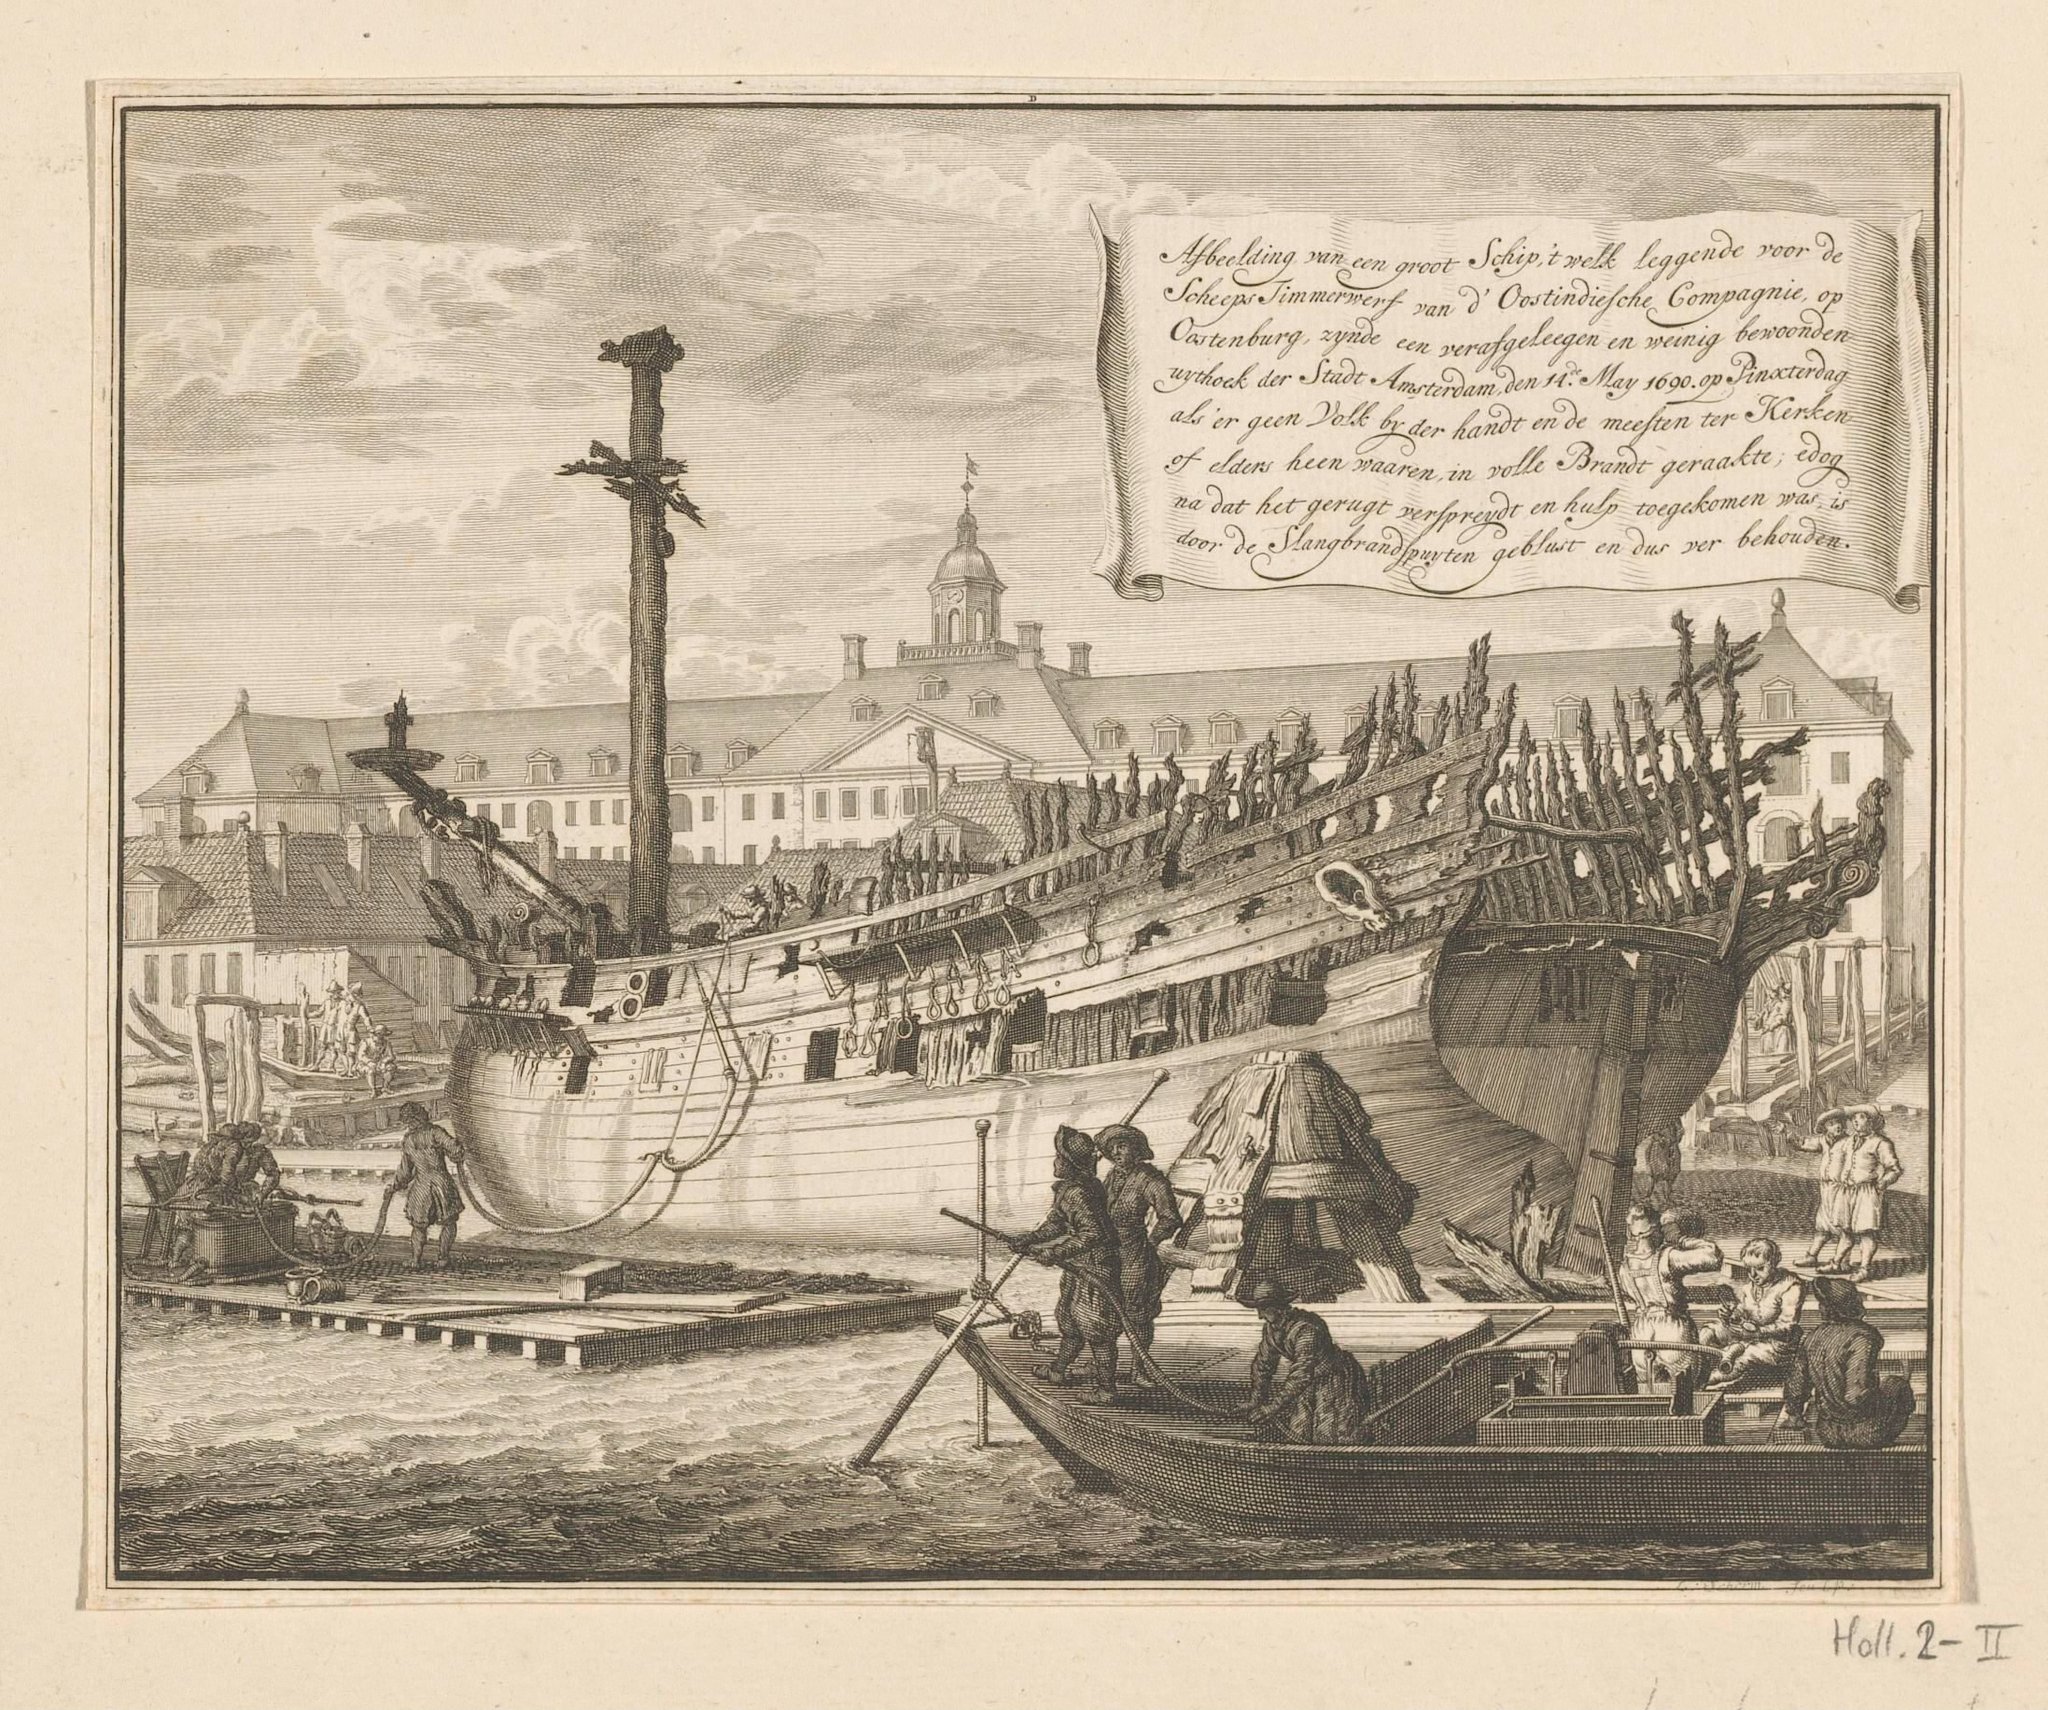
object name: book illustration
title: Deels verbrand schip op de VOC-scheepswerf op Oostenburg, 1690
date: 1690-1702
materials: paper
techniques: engraving, etching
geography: amsterdam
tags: painter, print maker, draughtsman, jan van der heyden, building a ship, ship under construction, pump (fire-extinguishing equipment), fire-hose, shipyard, shipdock, fire-extinguishing equipment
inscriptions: collector's mark: Lugt 2228, collector's mark: Lugt 195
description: Prent ook gebruikt in sommige exemplaren van: Heyden, Jan van der. Beschryving der nieuwlyks uitgevonden en geoctrojeerde slang-brand-spuiten en haare wyze van brand-blussen, tegenwoordig binnen Amsterdam in gebruik zijnde (…). 2e druk. Amsterdam: erfgenamen Jan van der Heyden, 1735. Verkleinde kopie naar de prent toegeschreven aan Jan van der Heyden (RP-P-OB-82.100, FMH 2301/19a).